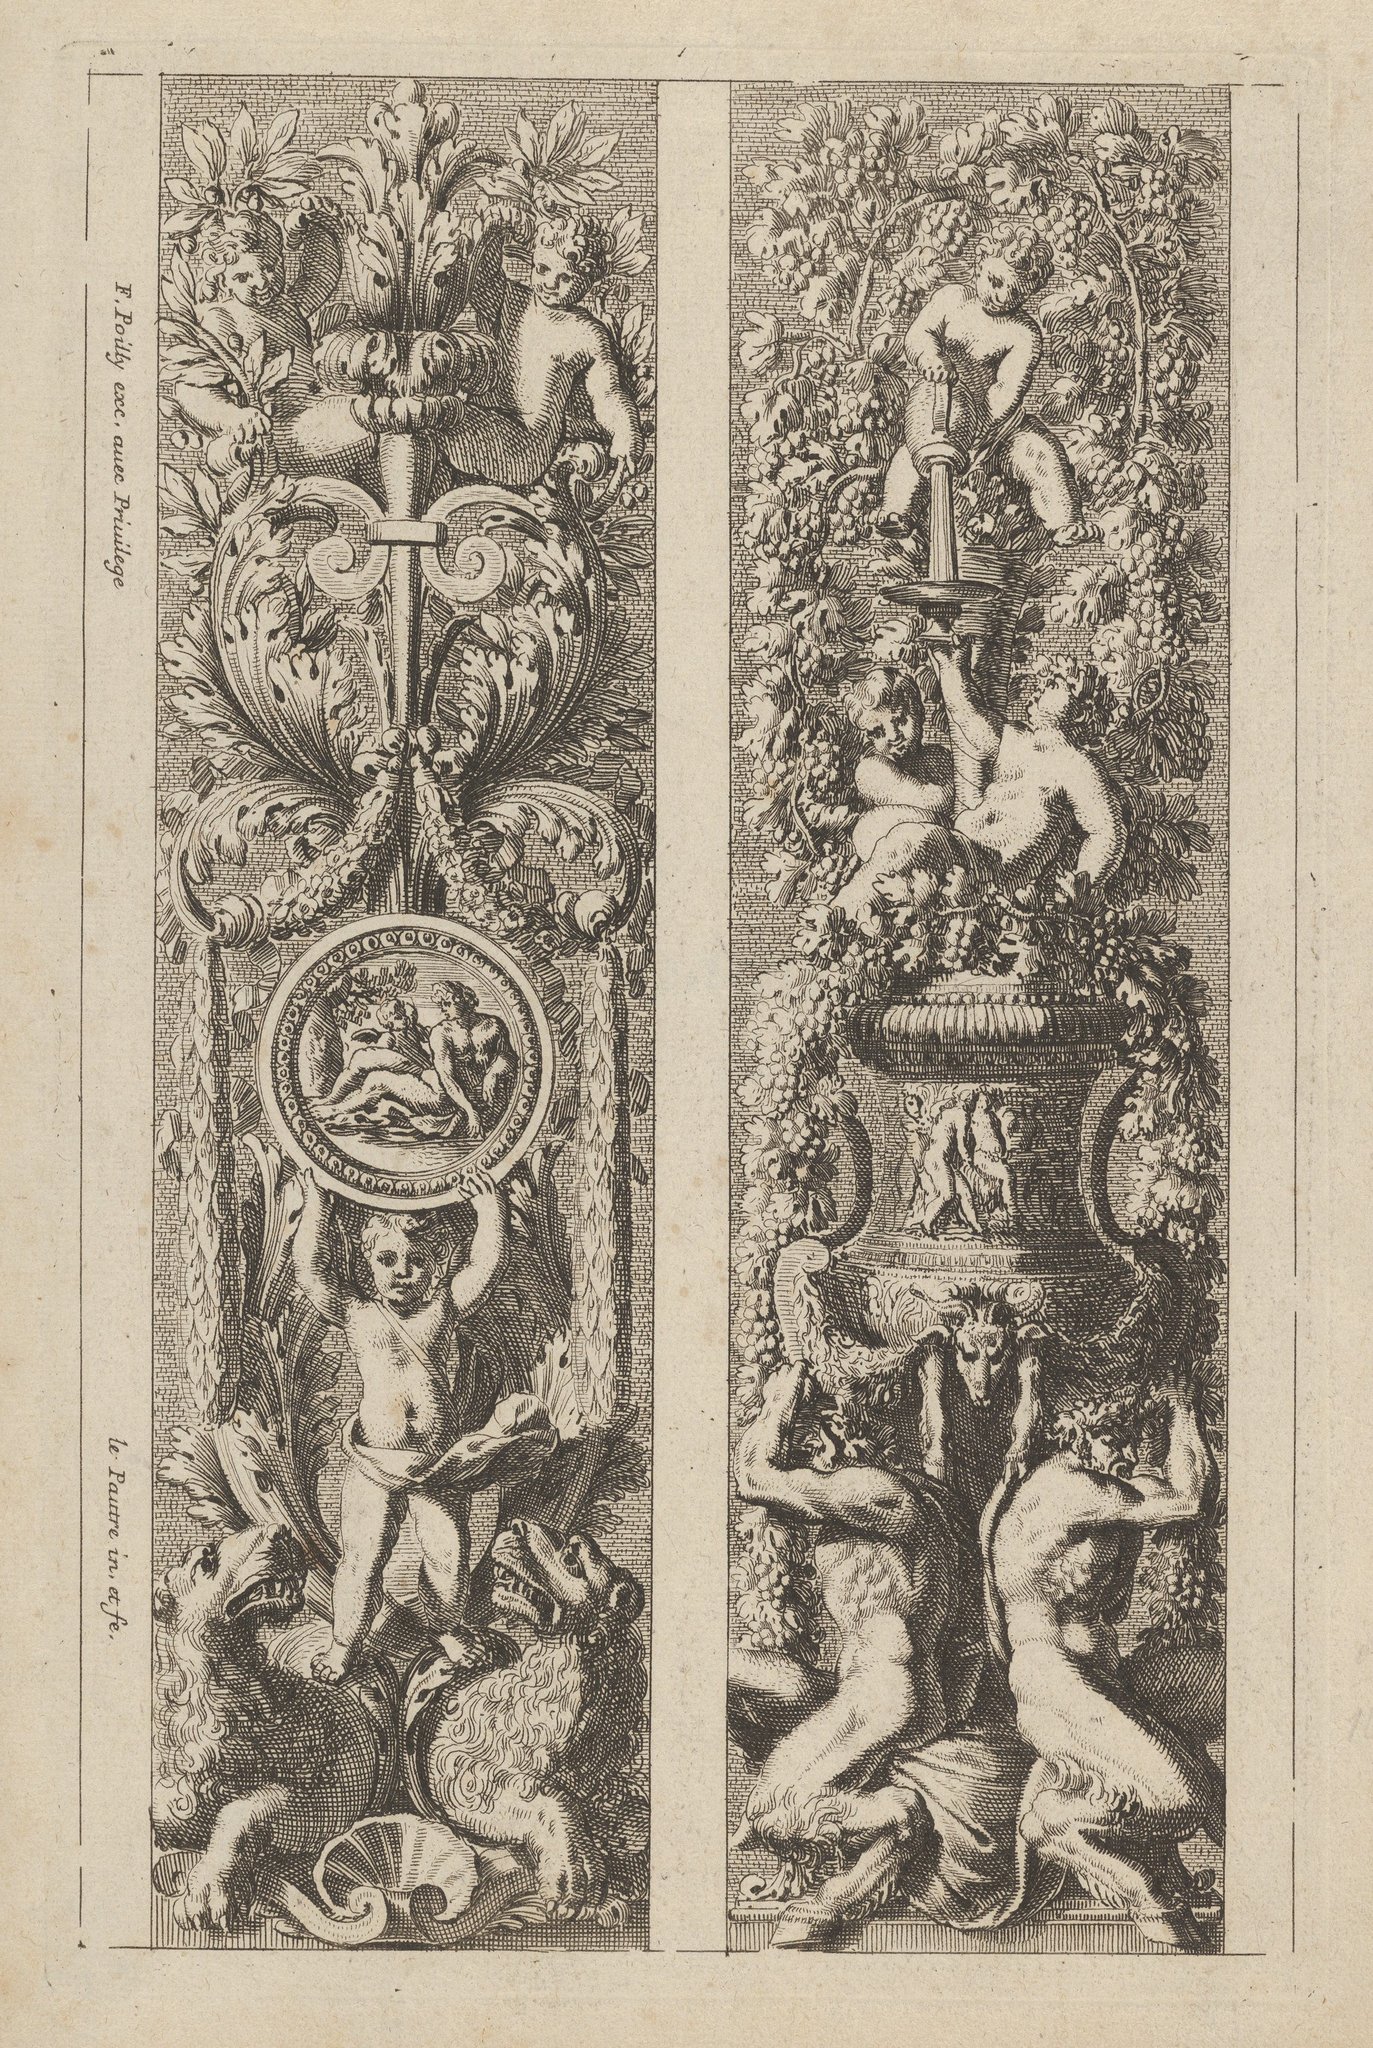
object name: print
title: Two Designs for Panels with Candelabra Decorations, from "Montants d'ornement"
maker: jean le pautre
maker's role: artist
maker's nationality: french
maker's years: 1618-1682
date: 1640-1682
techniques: etching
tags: putti,satyrs,lions,candelabra